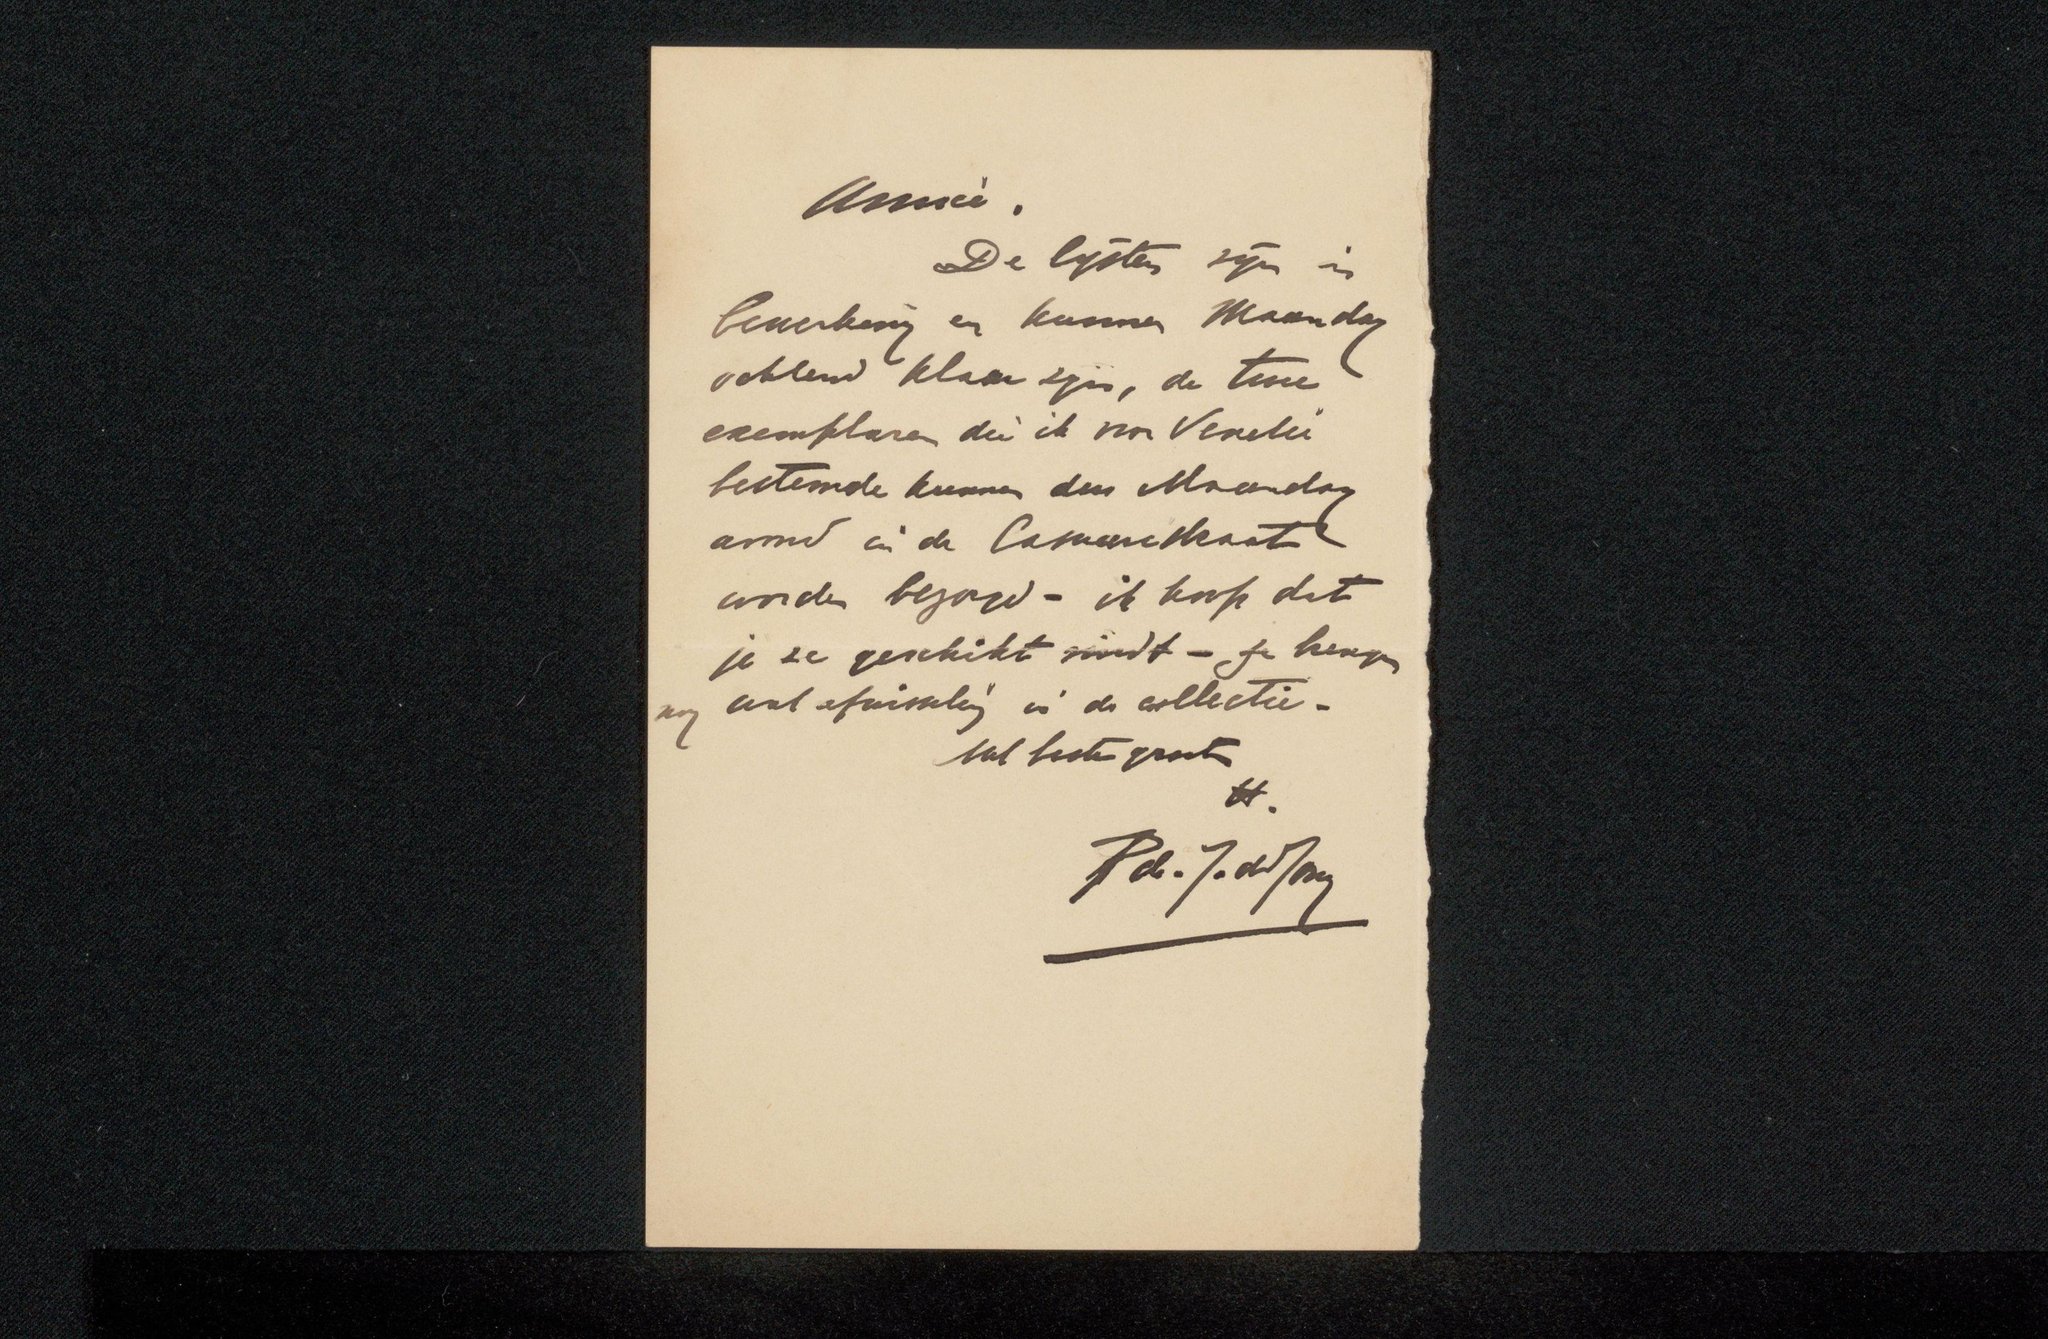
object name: letter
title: Brief aan Philip Zilcken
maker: pieter de josselin de jong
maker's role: draughtsman, painter, print maker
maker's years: 1861-1906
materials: ink, paper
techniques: writing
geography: the hague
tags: philip zilcken, exhibition ~ art, venice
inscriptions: collector's mark: ‘RPK’